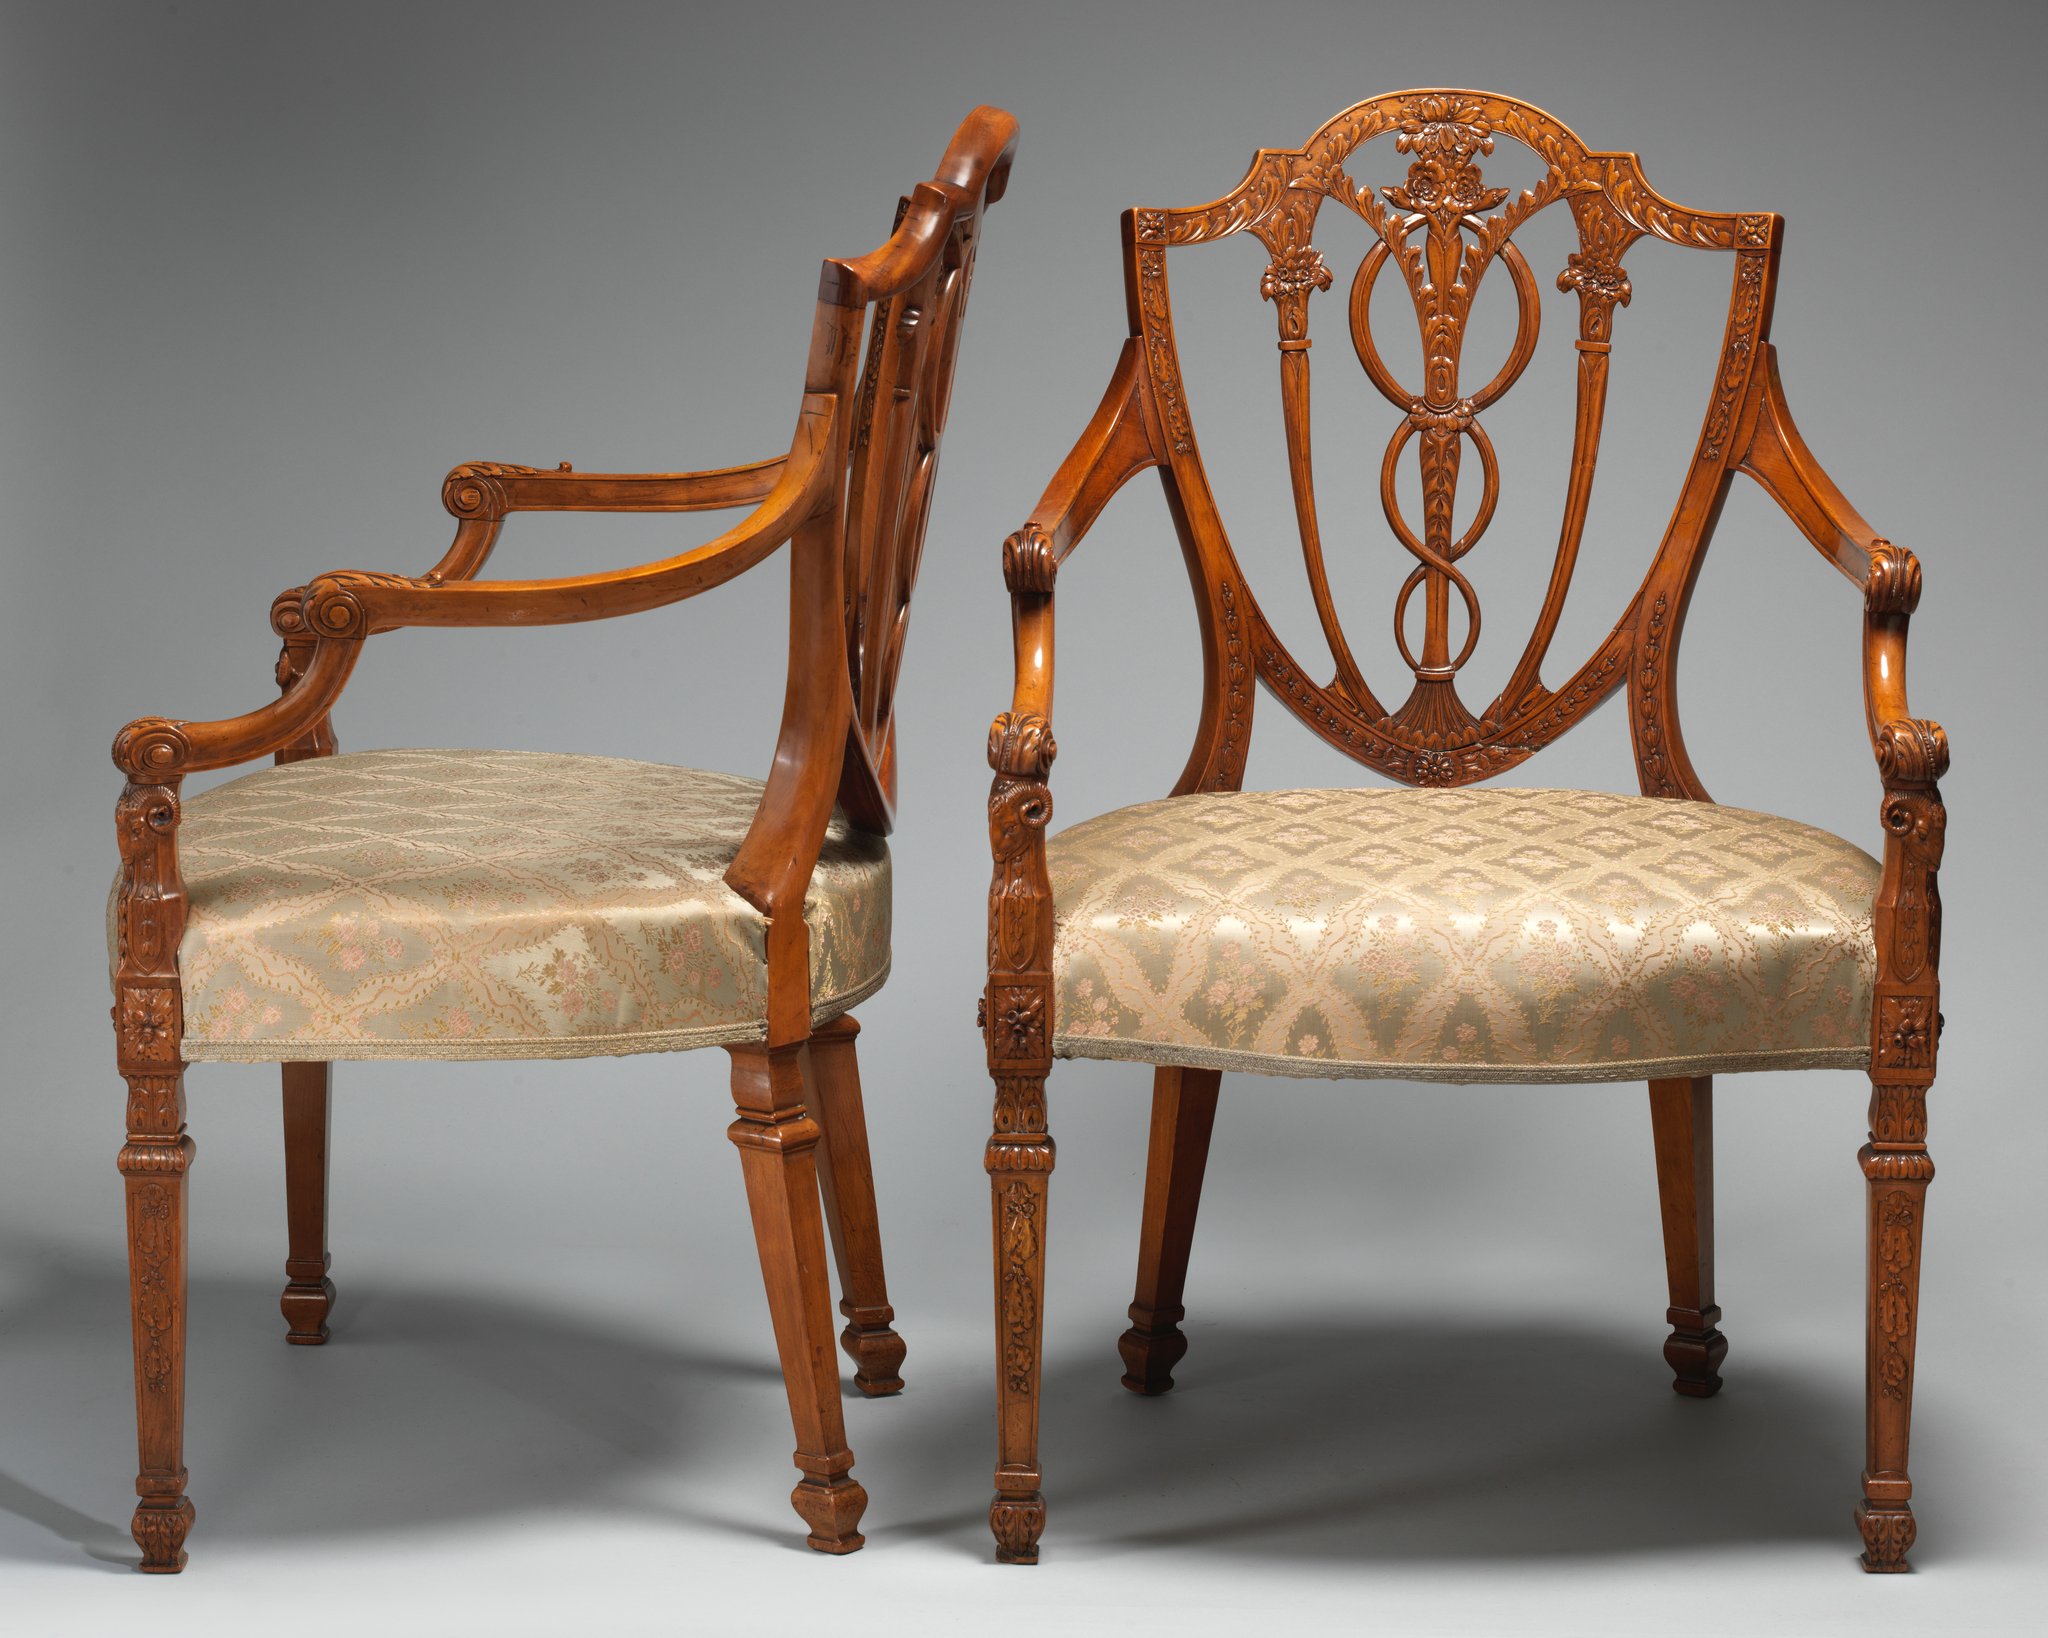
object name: armchair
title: Pair of armchairs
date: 1800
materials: wood, silk